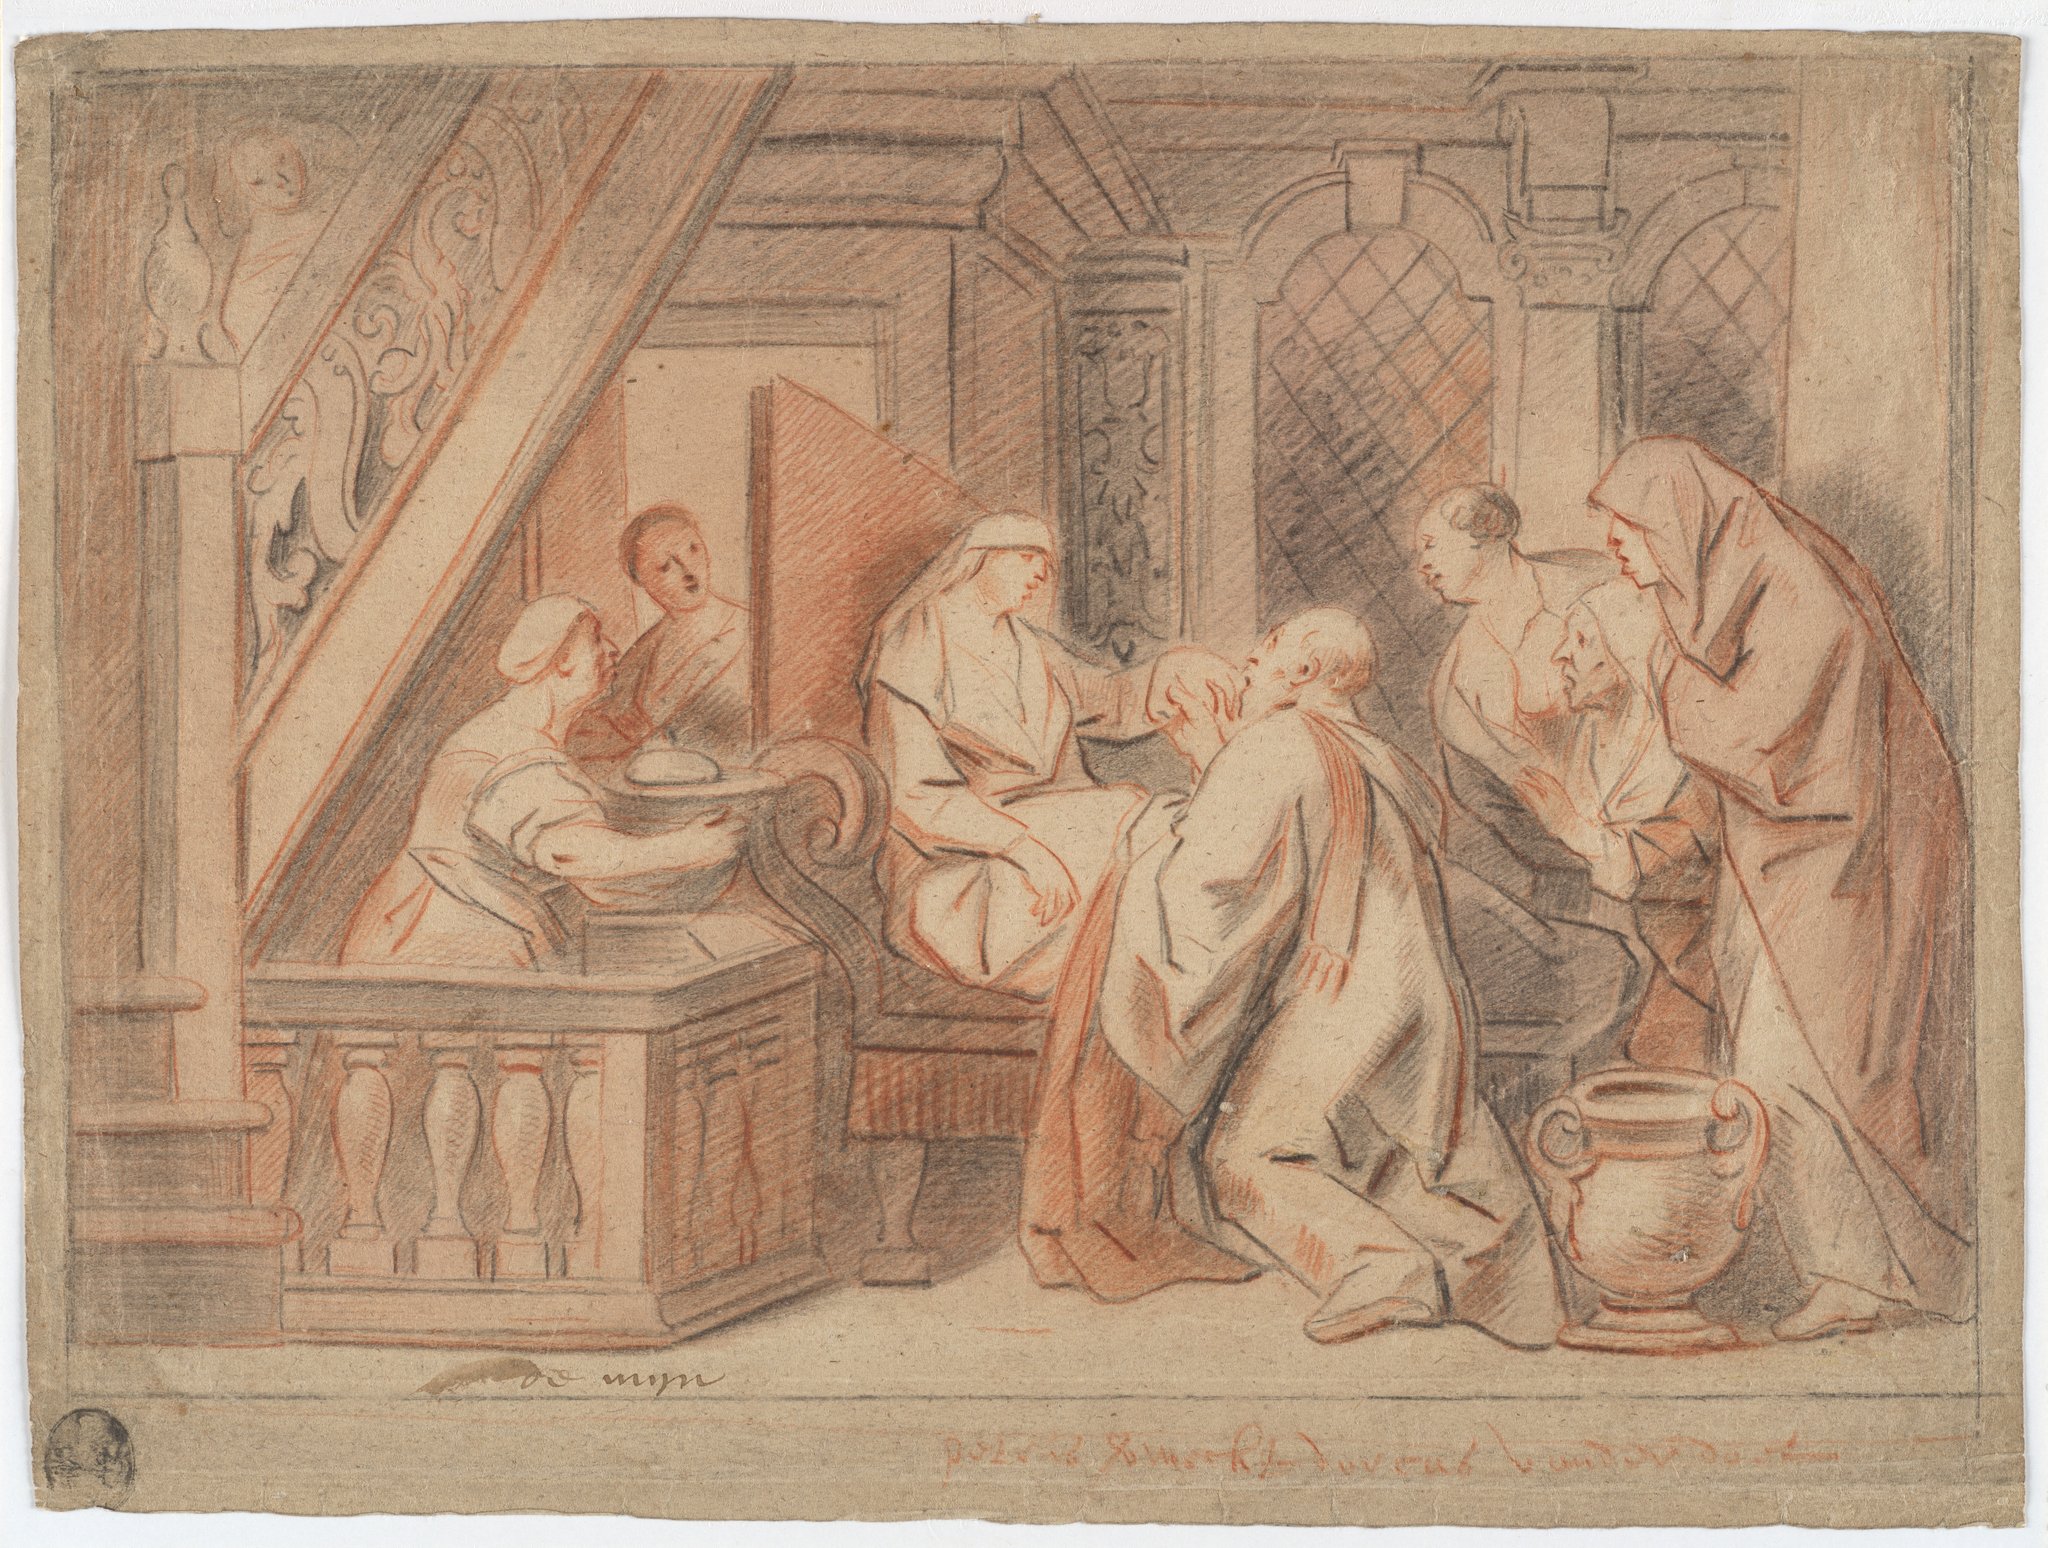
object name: drawing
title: Dorcas Raised From the Dead by Saint Peter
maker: jacob jordaens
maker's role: artist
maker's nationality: flemish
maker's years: 1593-1678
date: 1670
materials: chalk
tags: men,women,saint peter